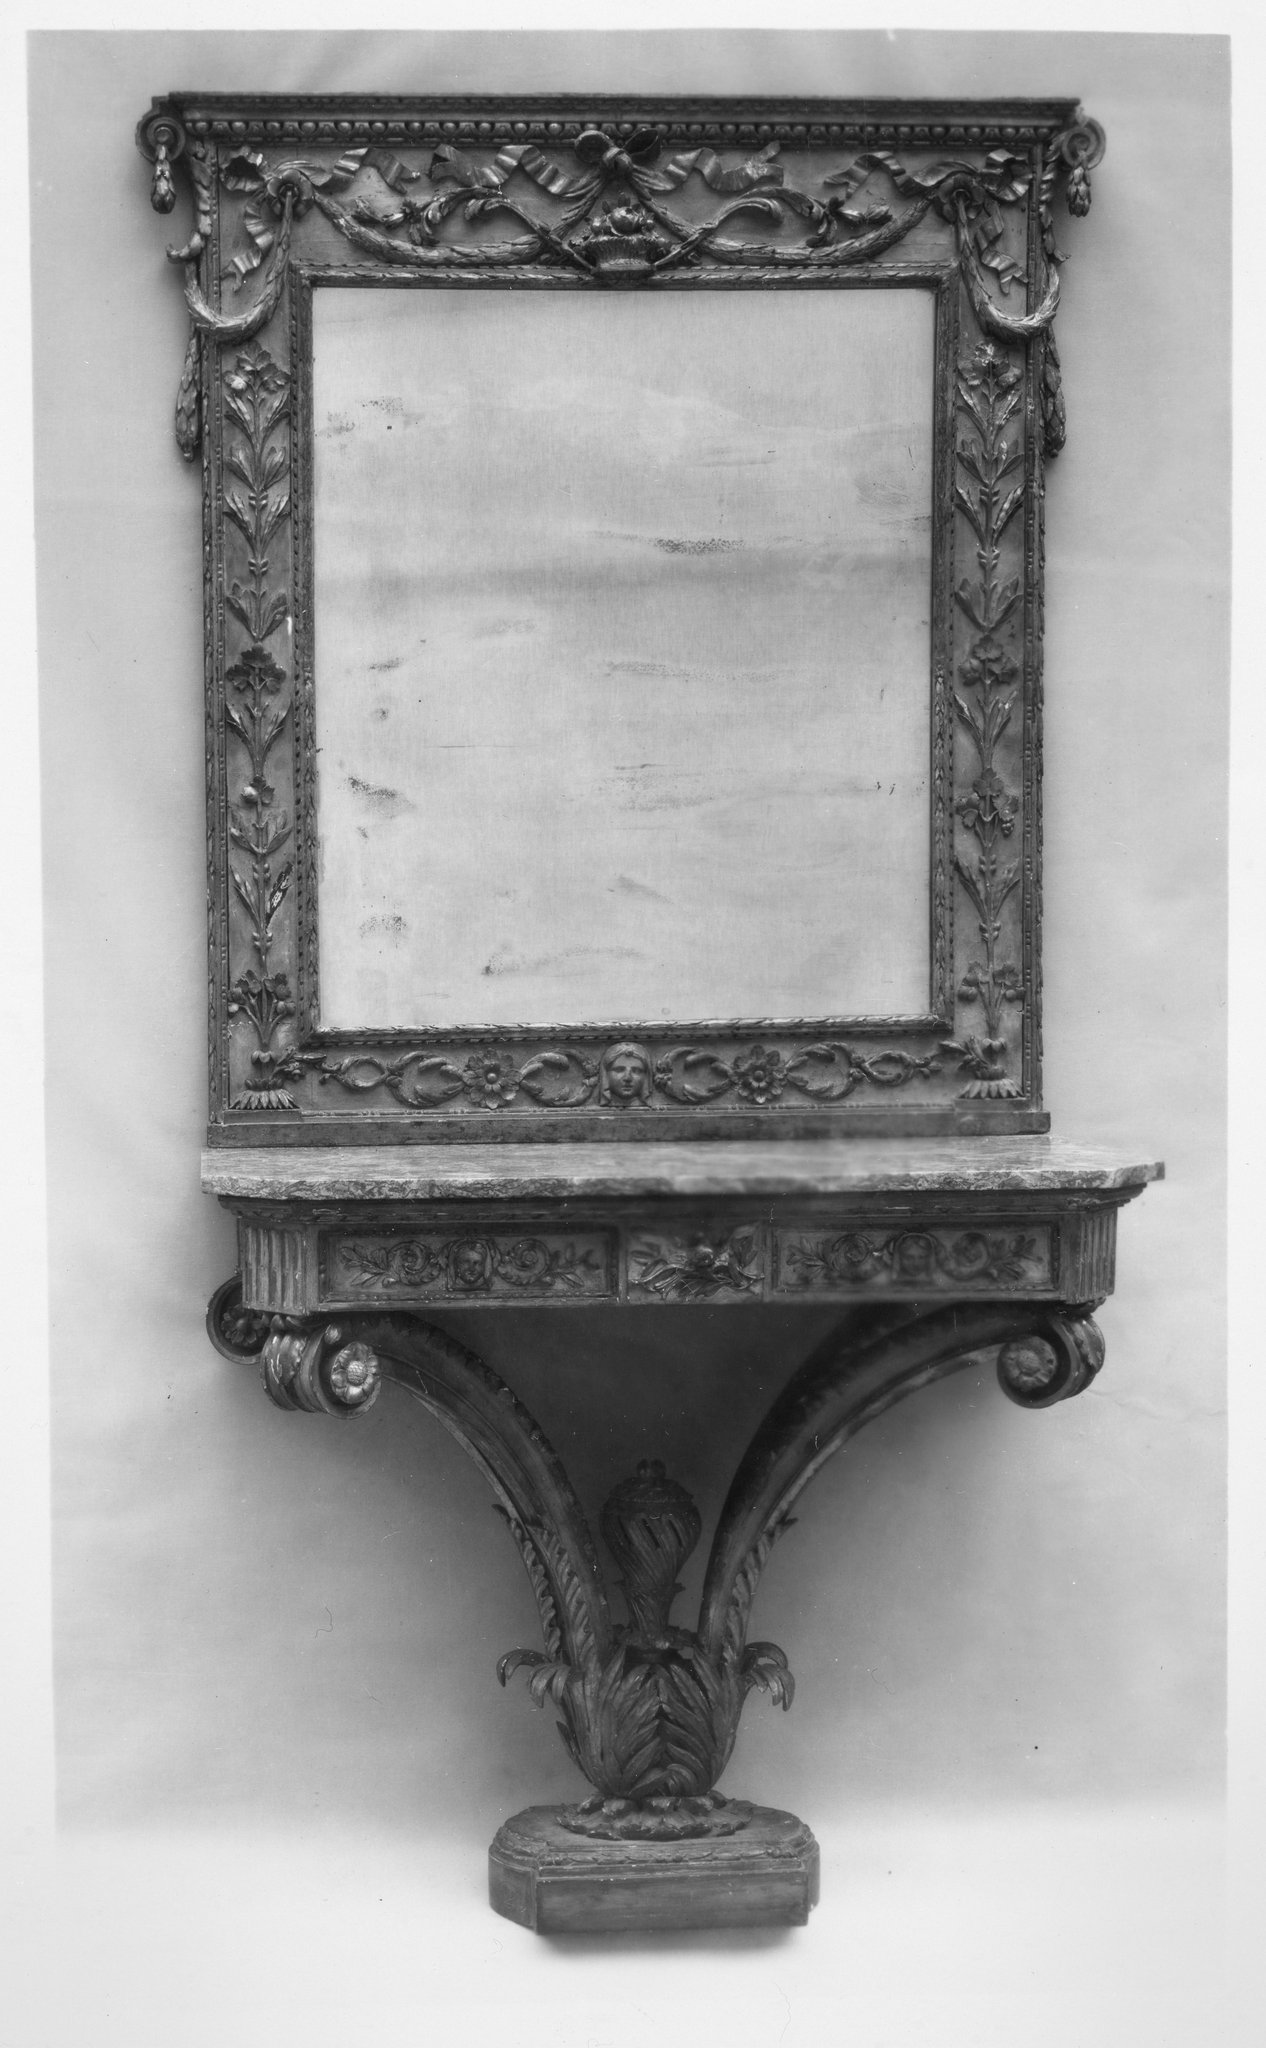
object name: console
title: Console (part of a set)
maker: giocondo (giuseppe) albertolli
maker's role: maker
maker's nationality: italian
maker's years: 1742-1839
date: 1770-1780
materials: marble, wood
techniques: gilding, painting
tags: faces,flowers